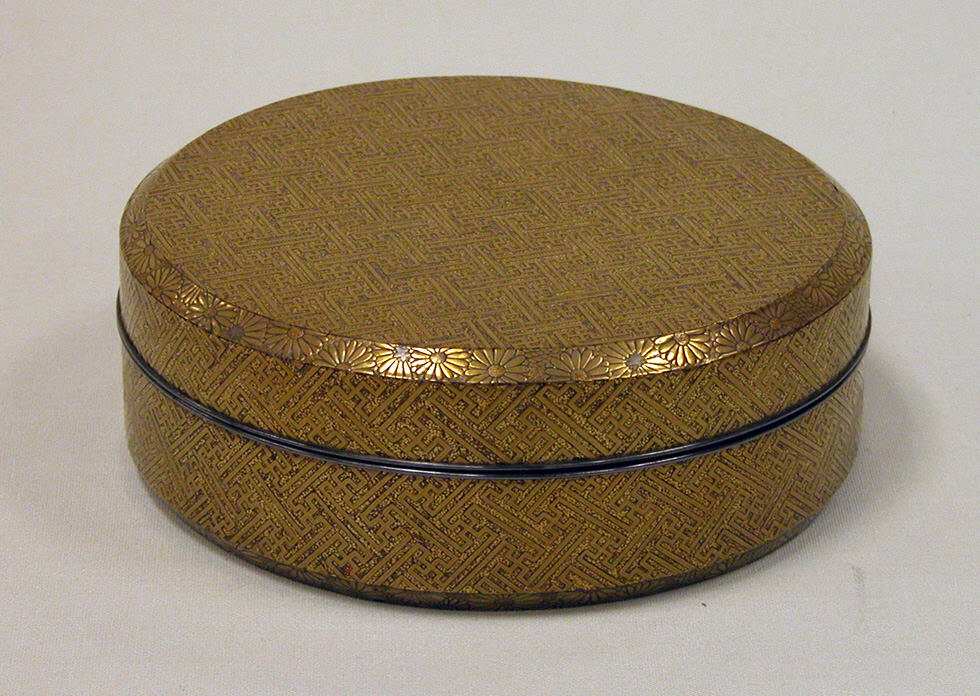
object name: box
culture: japanese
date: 1701-1800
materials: gold, lacquer, mother of pearl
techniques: inlay